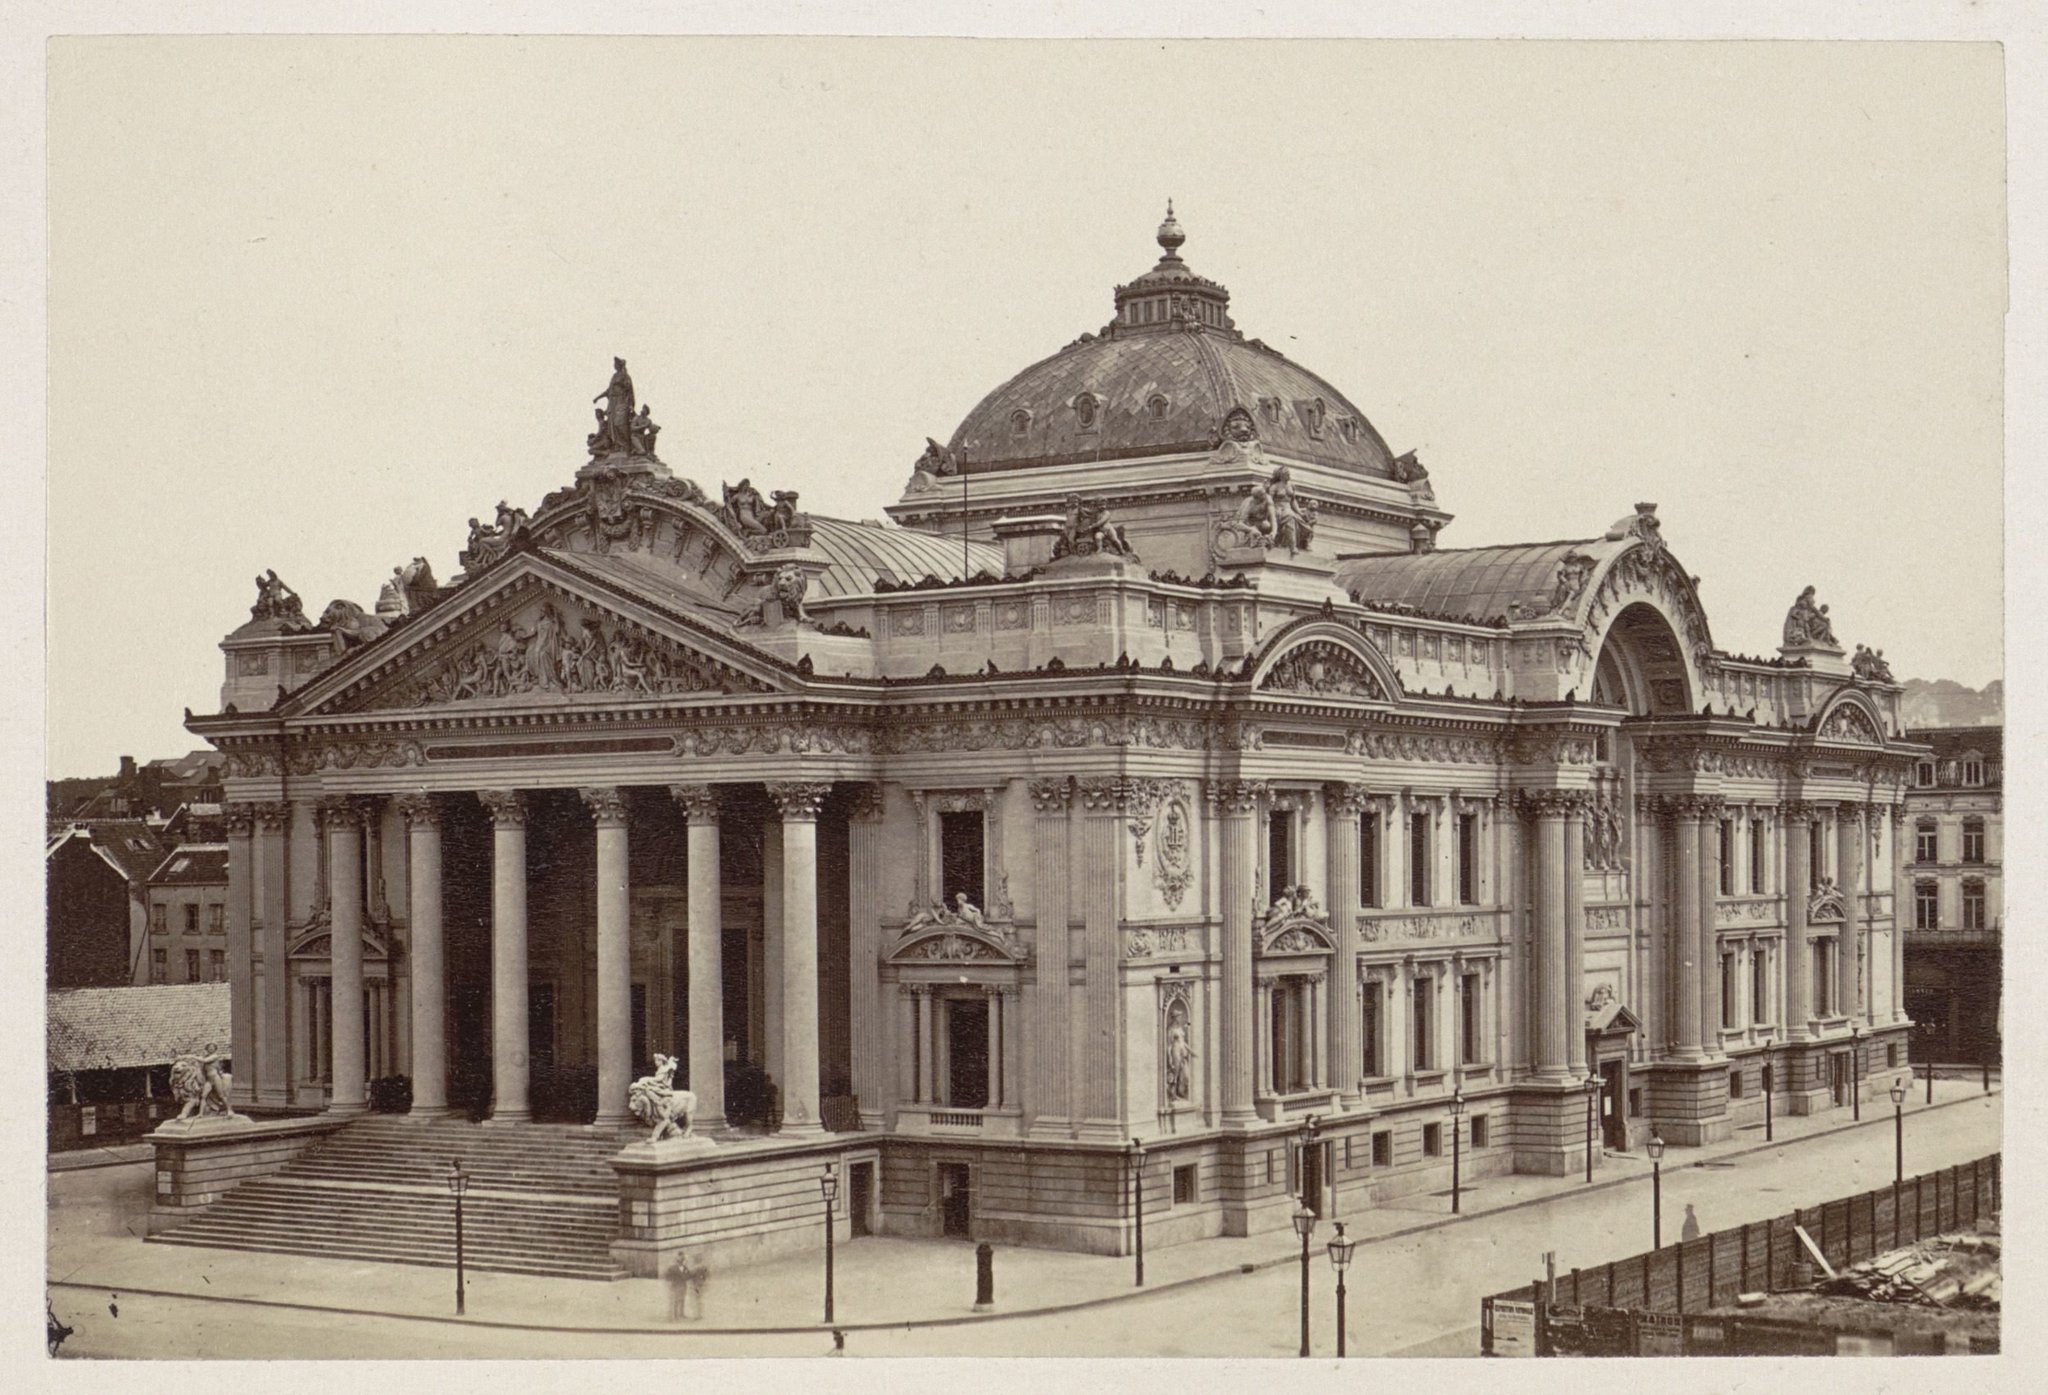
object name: photograph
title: Börsen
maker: Anonymous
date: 1878-1890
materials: photographic support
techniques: albumen print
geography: brussels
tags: stock exchange, stock-market, exterior ~ representation of a building, brussels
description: Onderdeel van Reisalbum Europese steden, vermoedelijk Zweeds.